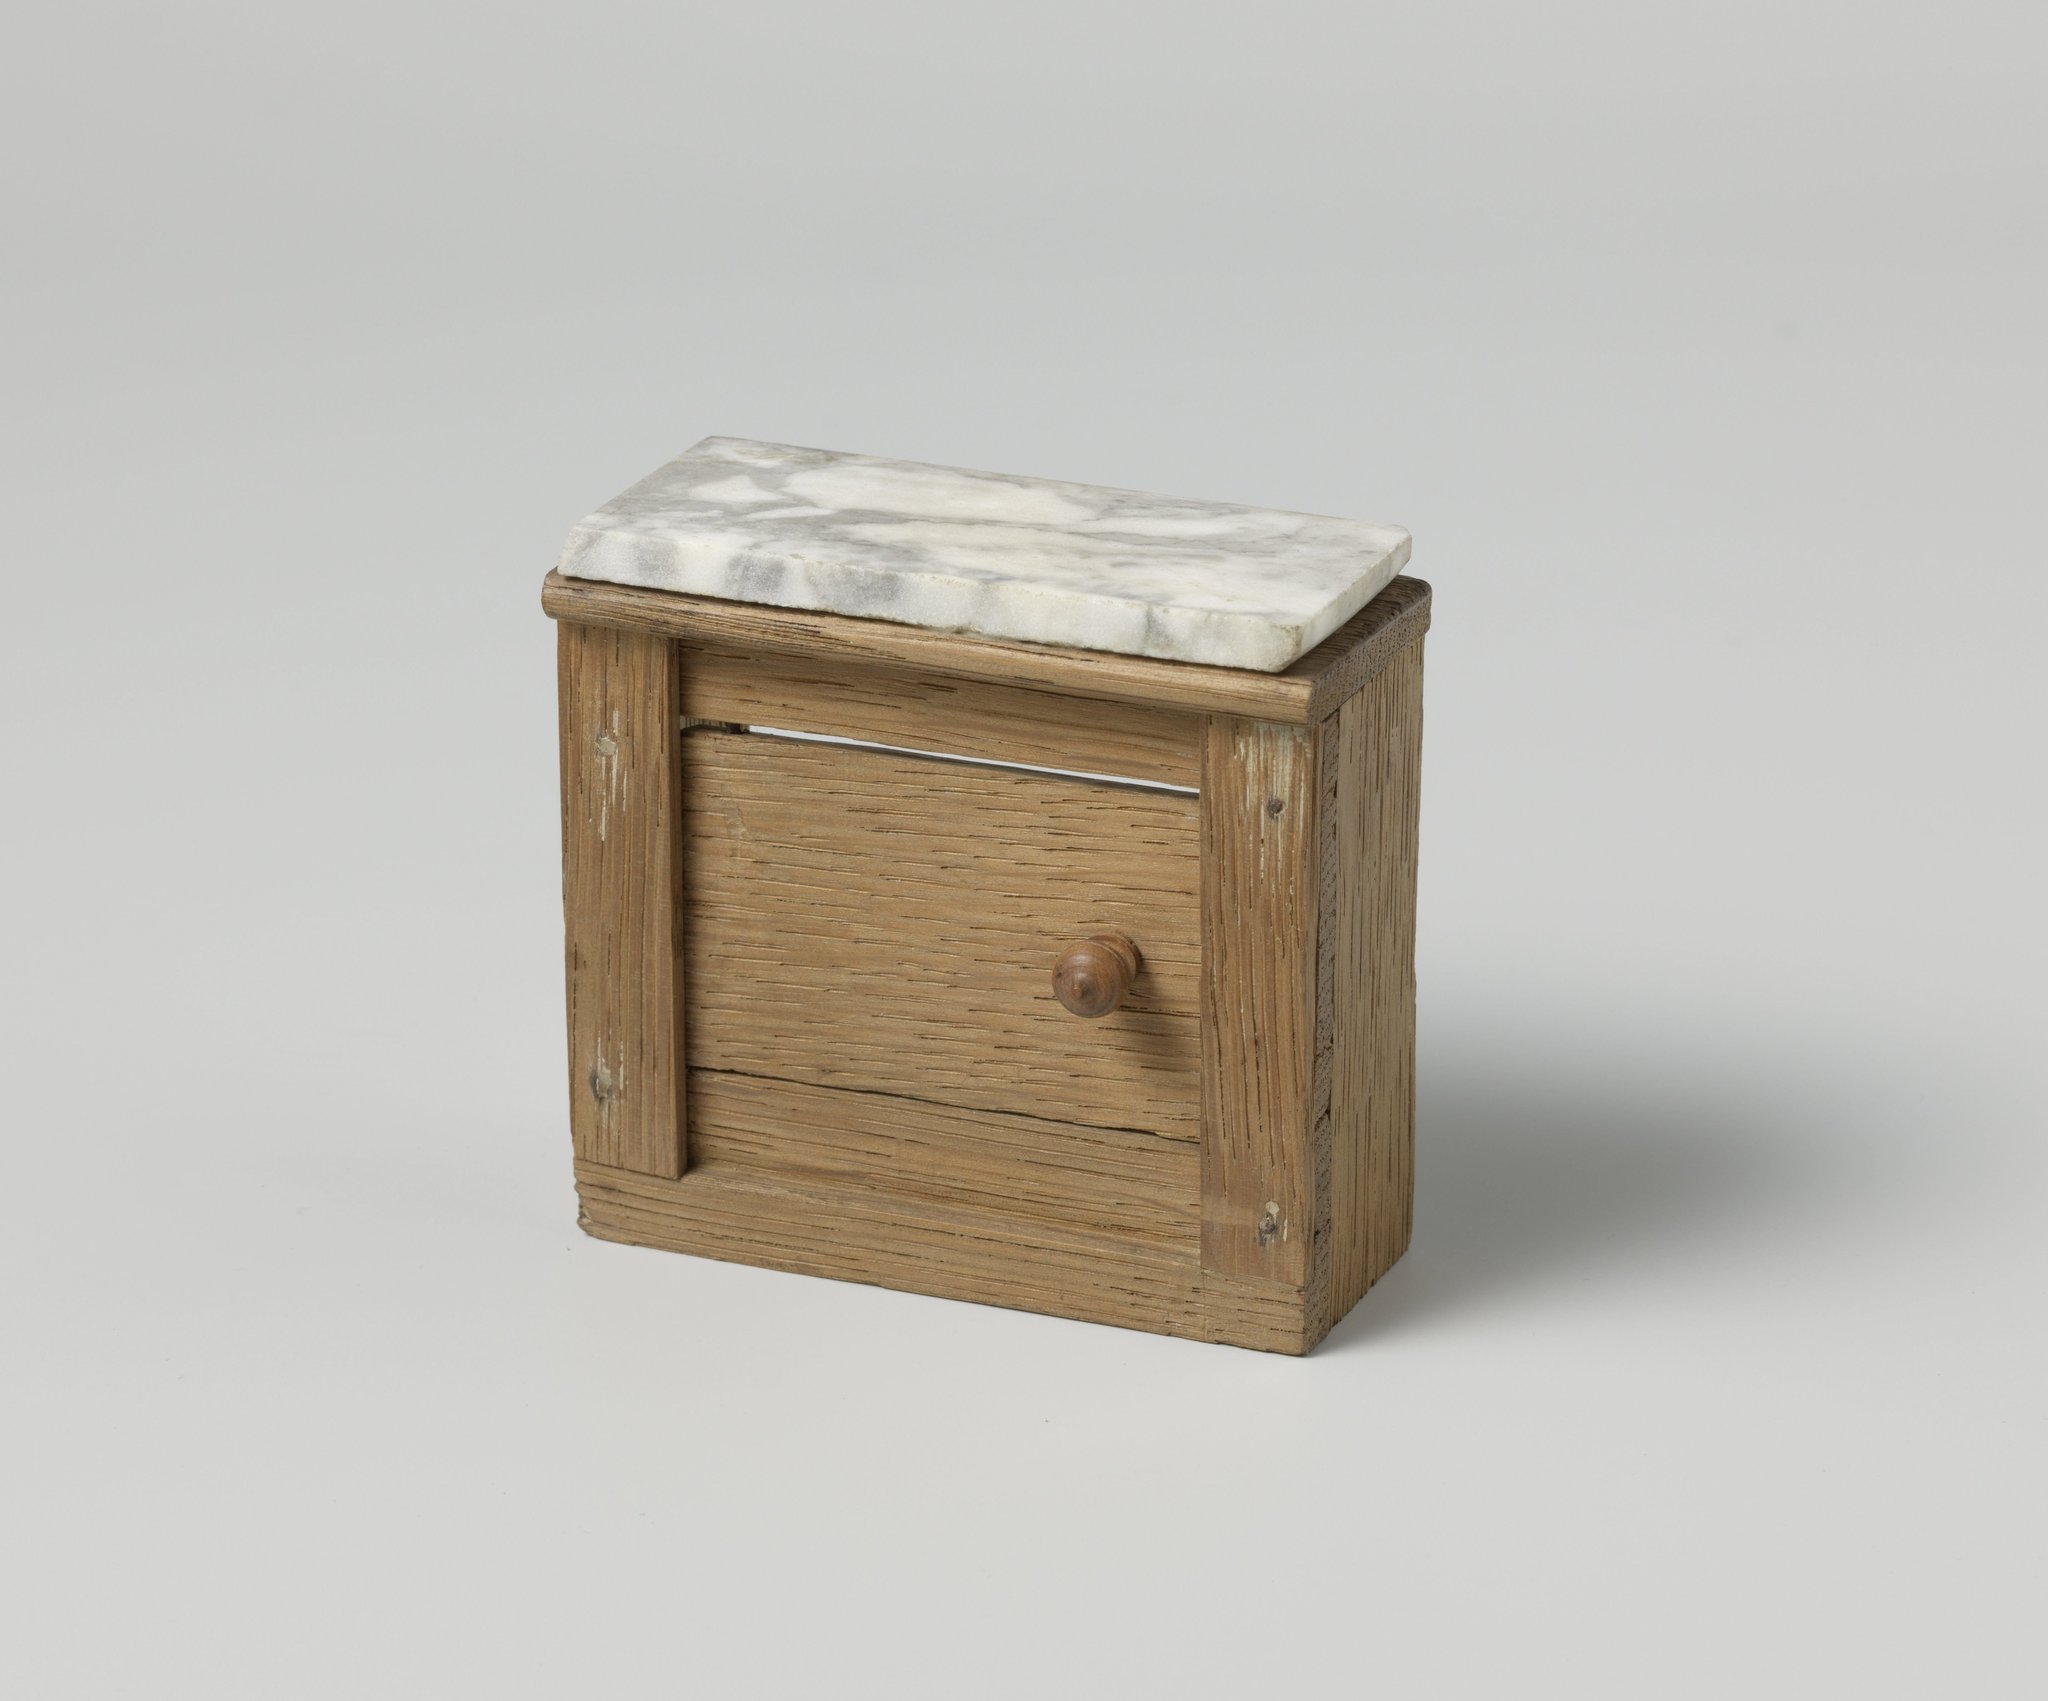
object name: aanrechtkast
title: Aanrechtkast met marmeren blad en openstaande deur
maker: Anonymous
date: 1750-1800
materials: wood, marble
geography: amsterdam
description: Een eikenhouten aanrechtkast zonder bodem en achterkant, met openstaande deur met palmhouten ronde knop. Op het bovenblad is een stuk marmer geplakt.